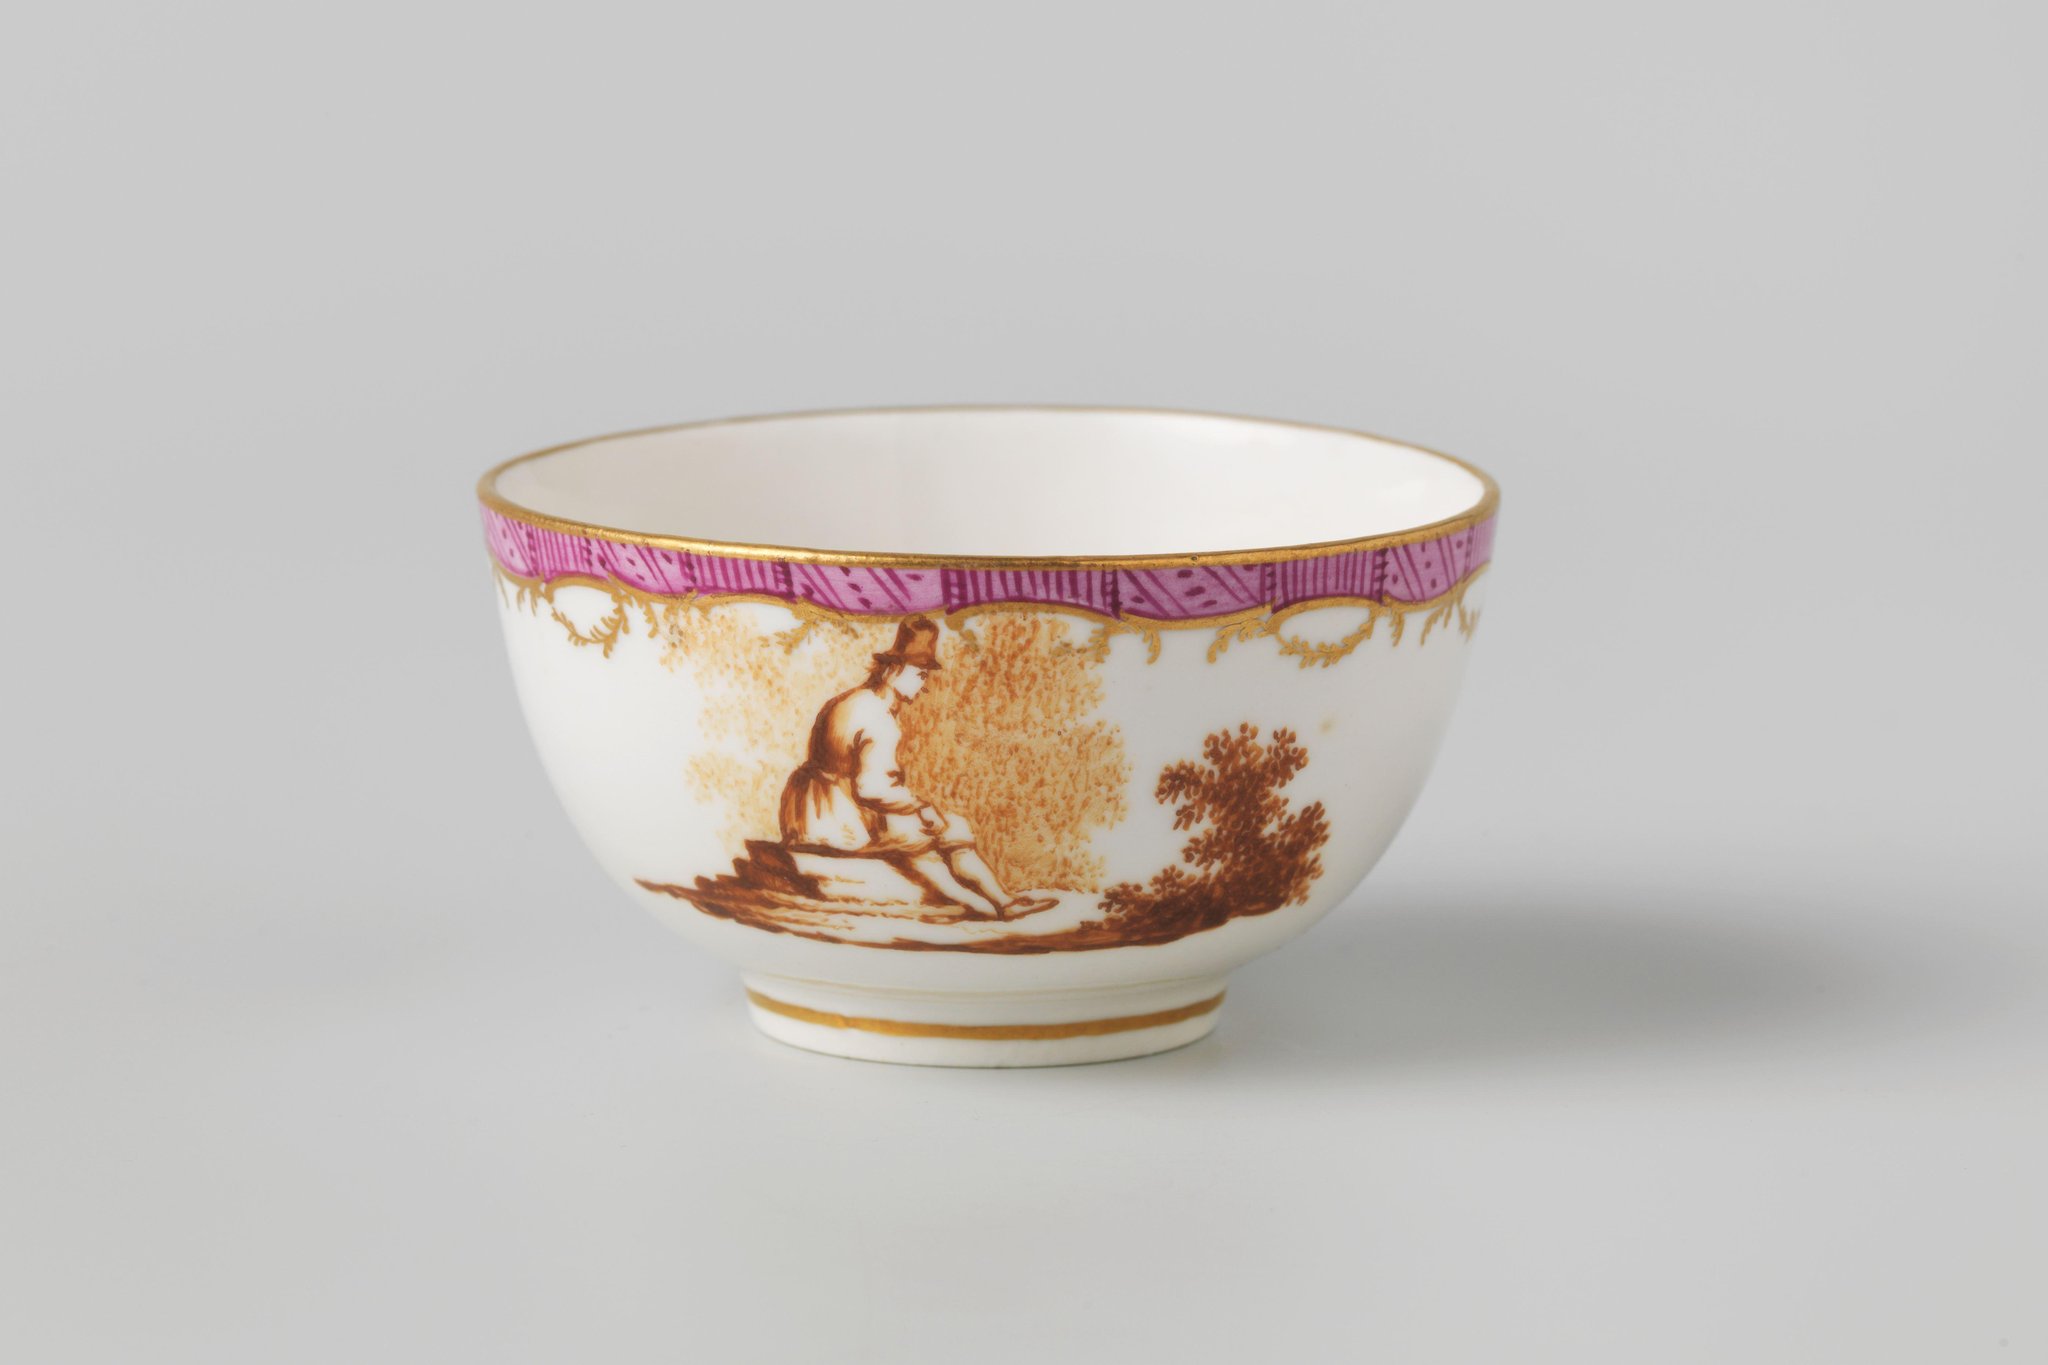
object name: tea cup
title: Theekop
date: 1774-1778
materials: porcelain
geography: loosdrecht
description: Theekop zonder oor van porselein. Beschilderd in sepia met figuren in een landschap. Langs de randen een lila fries tussen gouden biezen.